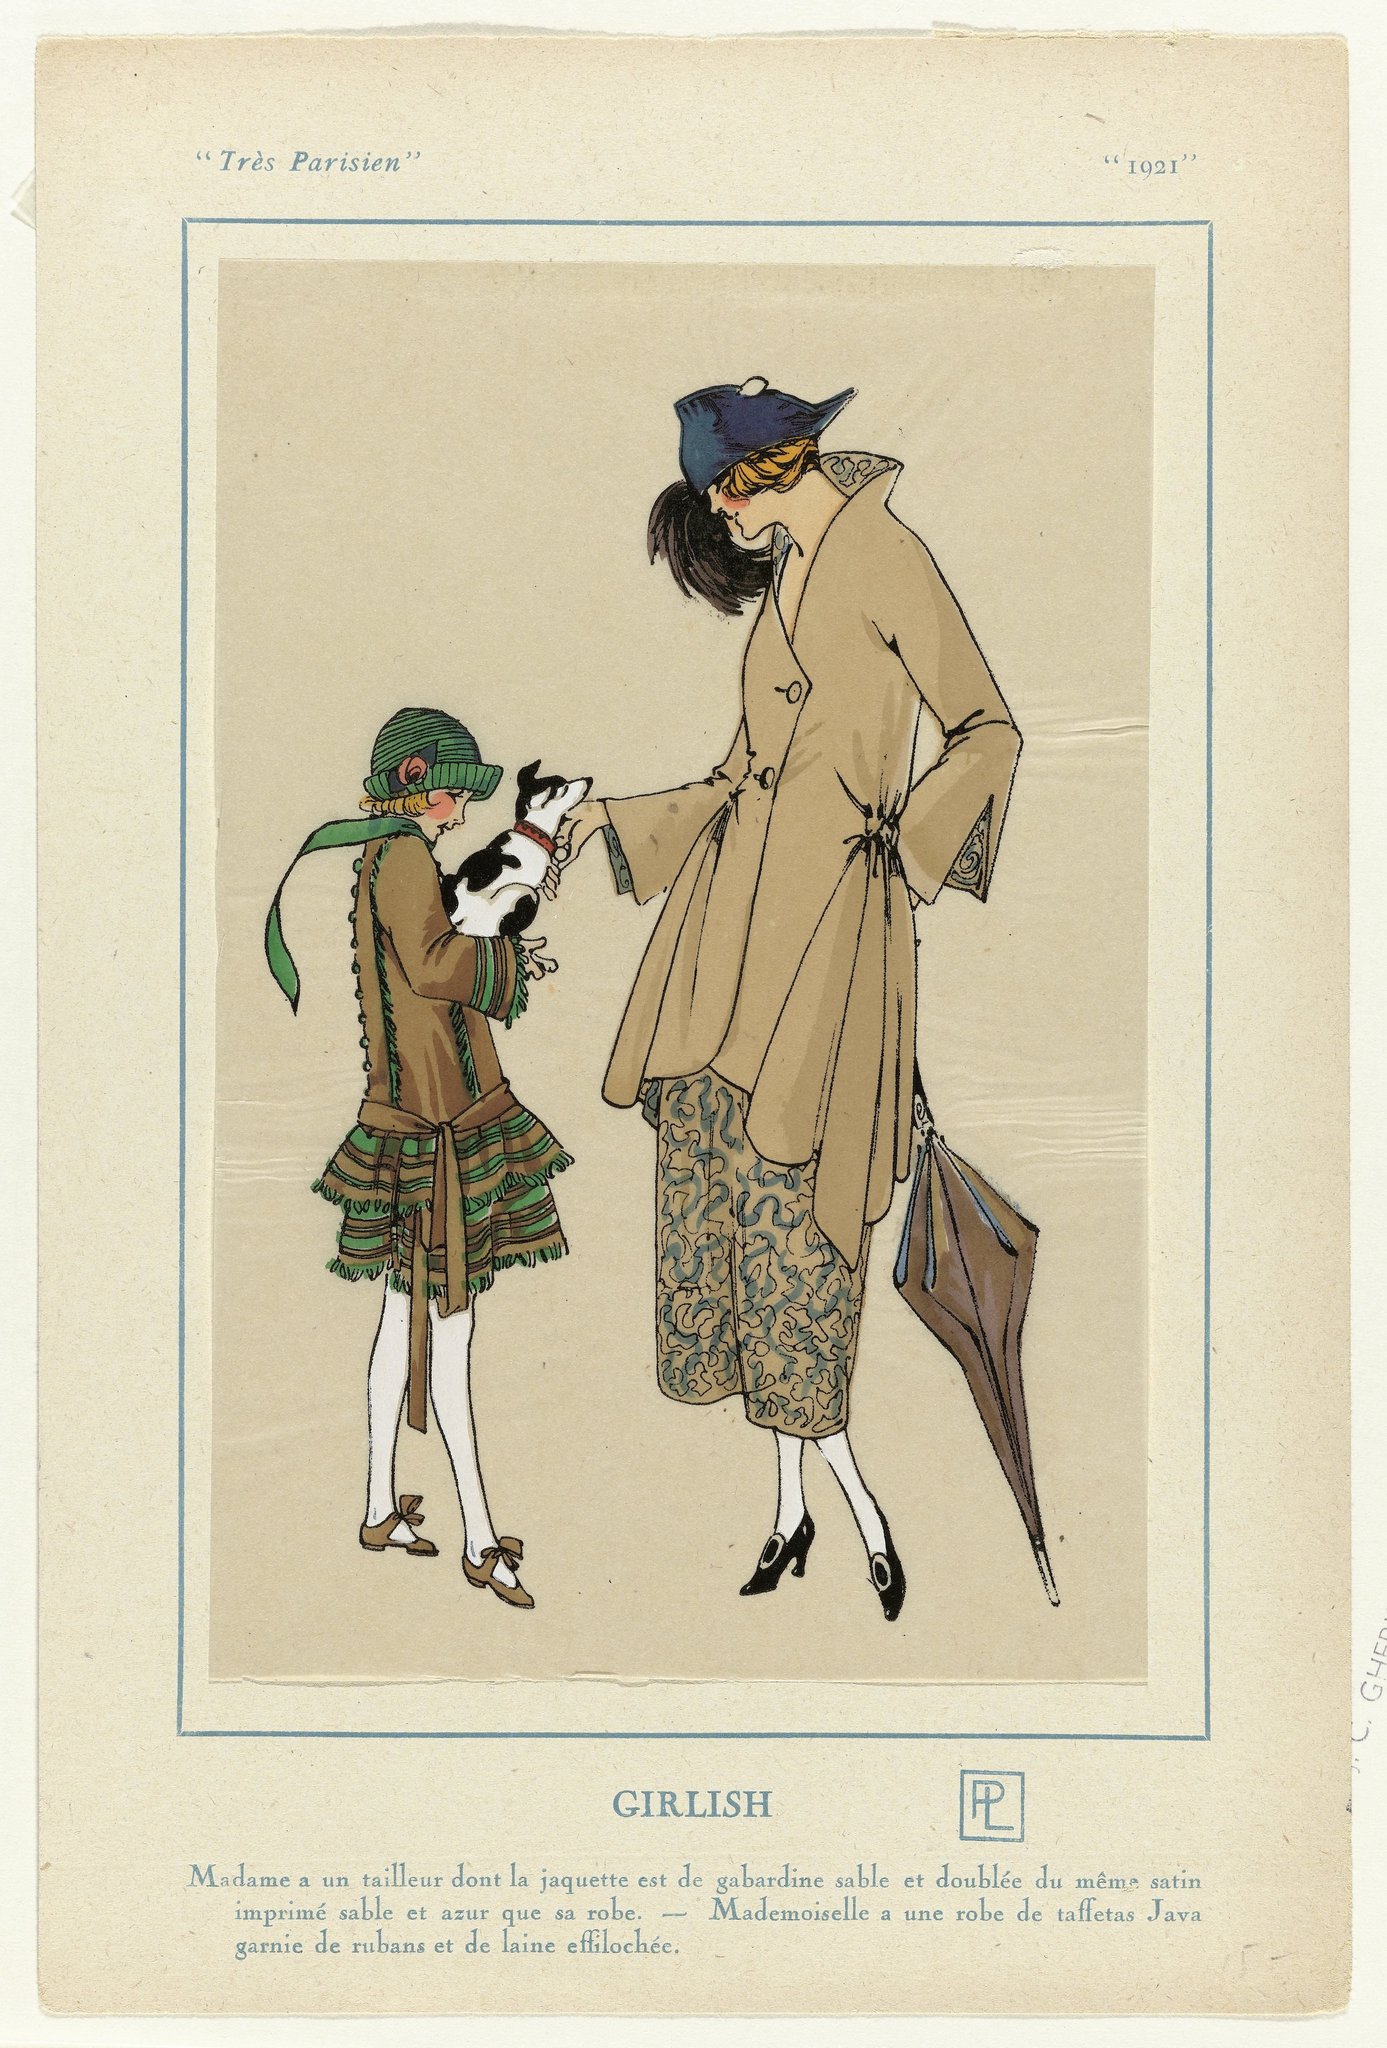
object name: fashion print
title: Très Parisien, 1921 : GIRLISH / Madame a un tailleur (...)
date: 1921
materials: paper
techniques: hand coloring, letterpress printing, lithography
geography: paris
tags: ensembles of pieces of clothing (suit) (+ women's clothes), head-gear (+ girls' clothes), shoes, sandals (+ girls' clothes), umbrella (+ women's clothes), coat (+ women's clothes), head-gear (+ women's clothes), fashion plates, dress, gown (+ women's clothes), dog, dress, gown (+ girls' clothes)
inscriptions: title: ‘" Très Parisien" / "1921"’, caption: ‘GIRLISH / Madame a un tailleur dont la jaquette est de gabardine sable et doublée du même satin imprimé sable et azur que sa robe. - Mademoiselle a une robe de taffetas Java garnie de rubans et de laine effilochée.’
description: Vrouw in een tailleur (mantelpak) van 'gabardine sable' en gevoerd met hetzelfde bedrukte satijn in blauw en bruin als haar jurk. Meisje in een jurk van 'taffetas Java' (tafzijde) gegarneerd met linten en gerafelde wol. Accessories: hoed met pluim, cloche (pothoed), paraplu(?), schoenen, pumps. Prent uit het modetijdschrift Très Parisien (1920-1936).